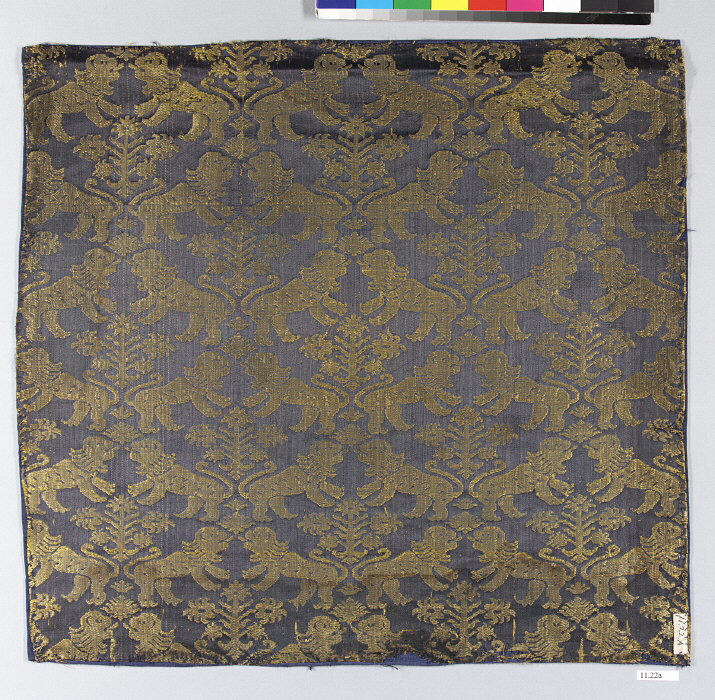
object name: piece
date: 1501-1600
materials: silk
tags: lions